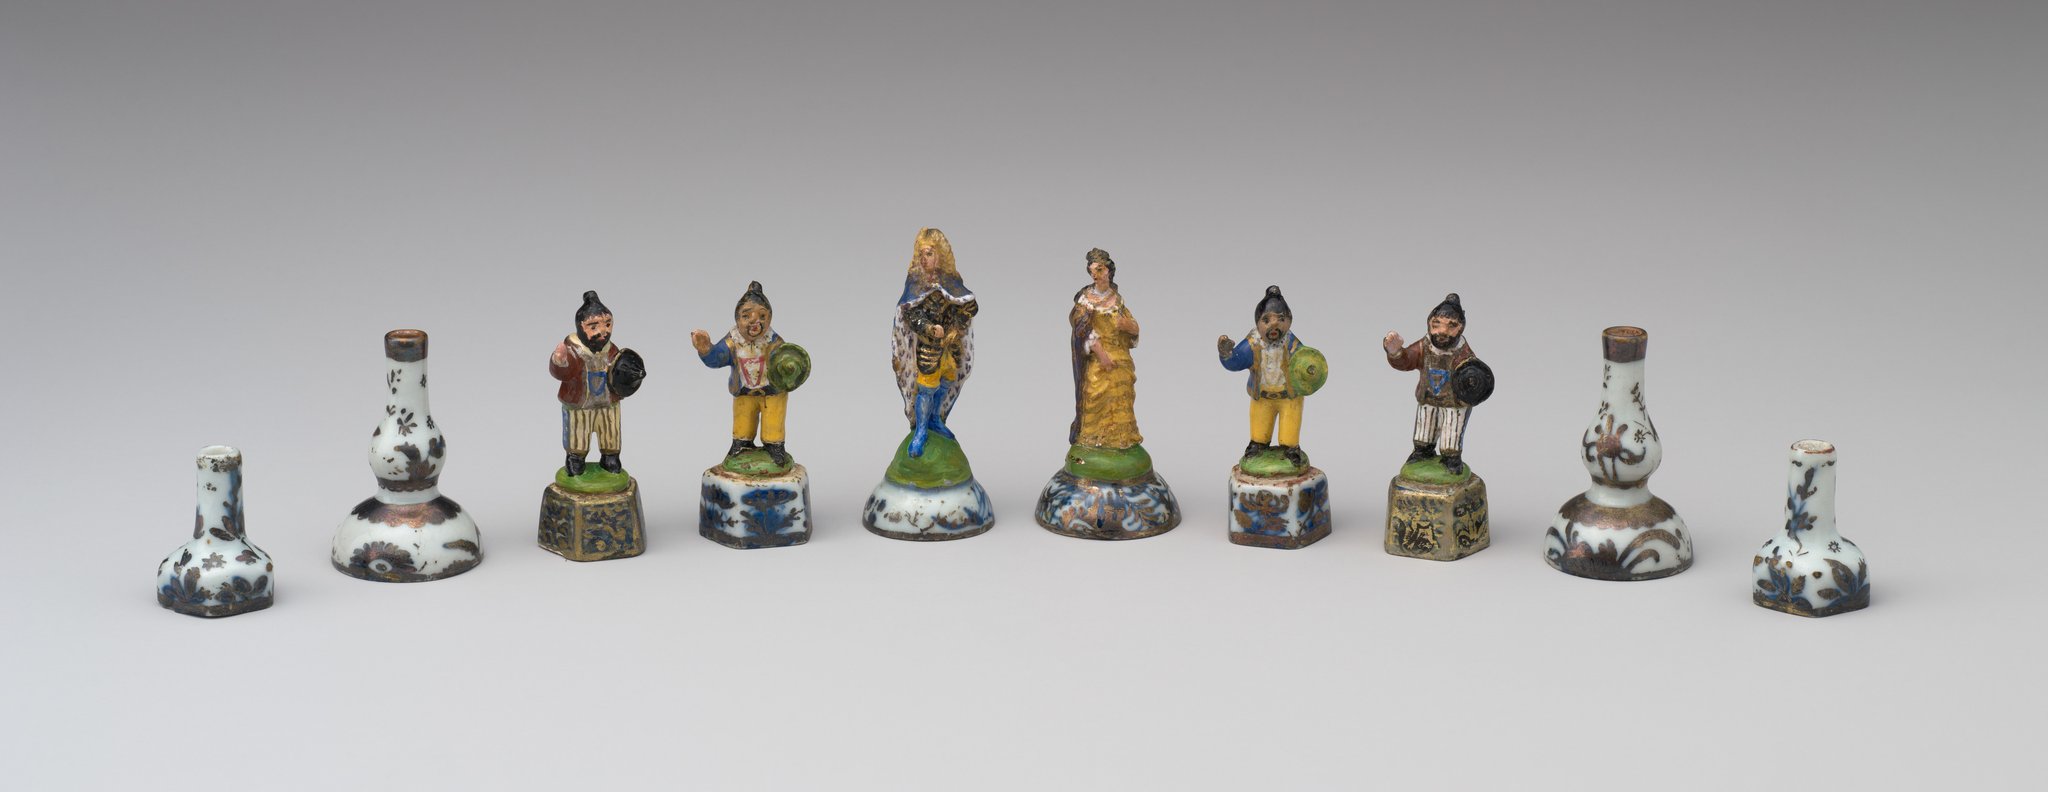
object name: chessman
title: Chessmen (32)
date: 1801-1833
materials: porcelain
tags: chess